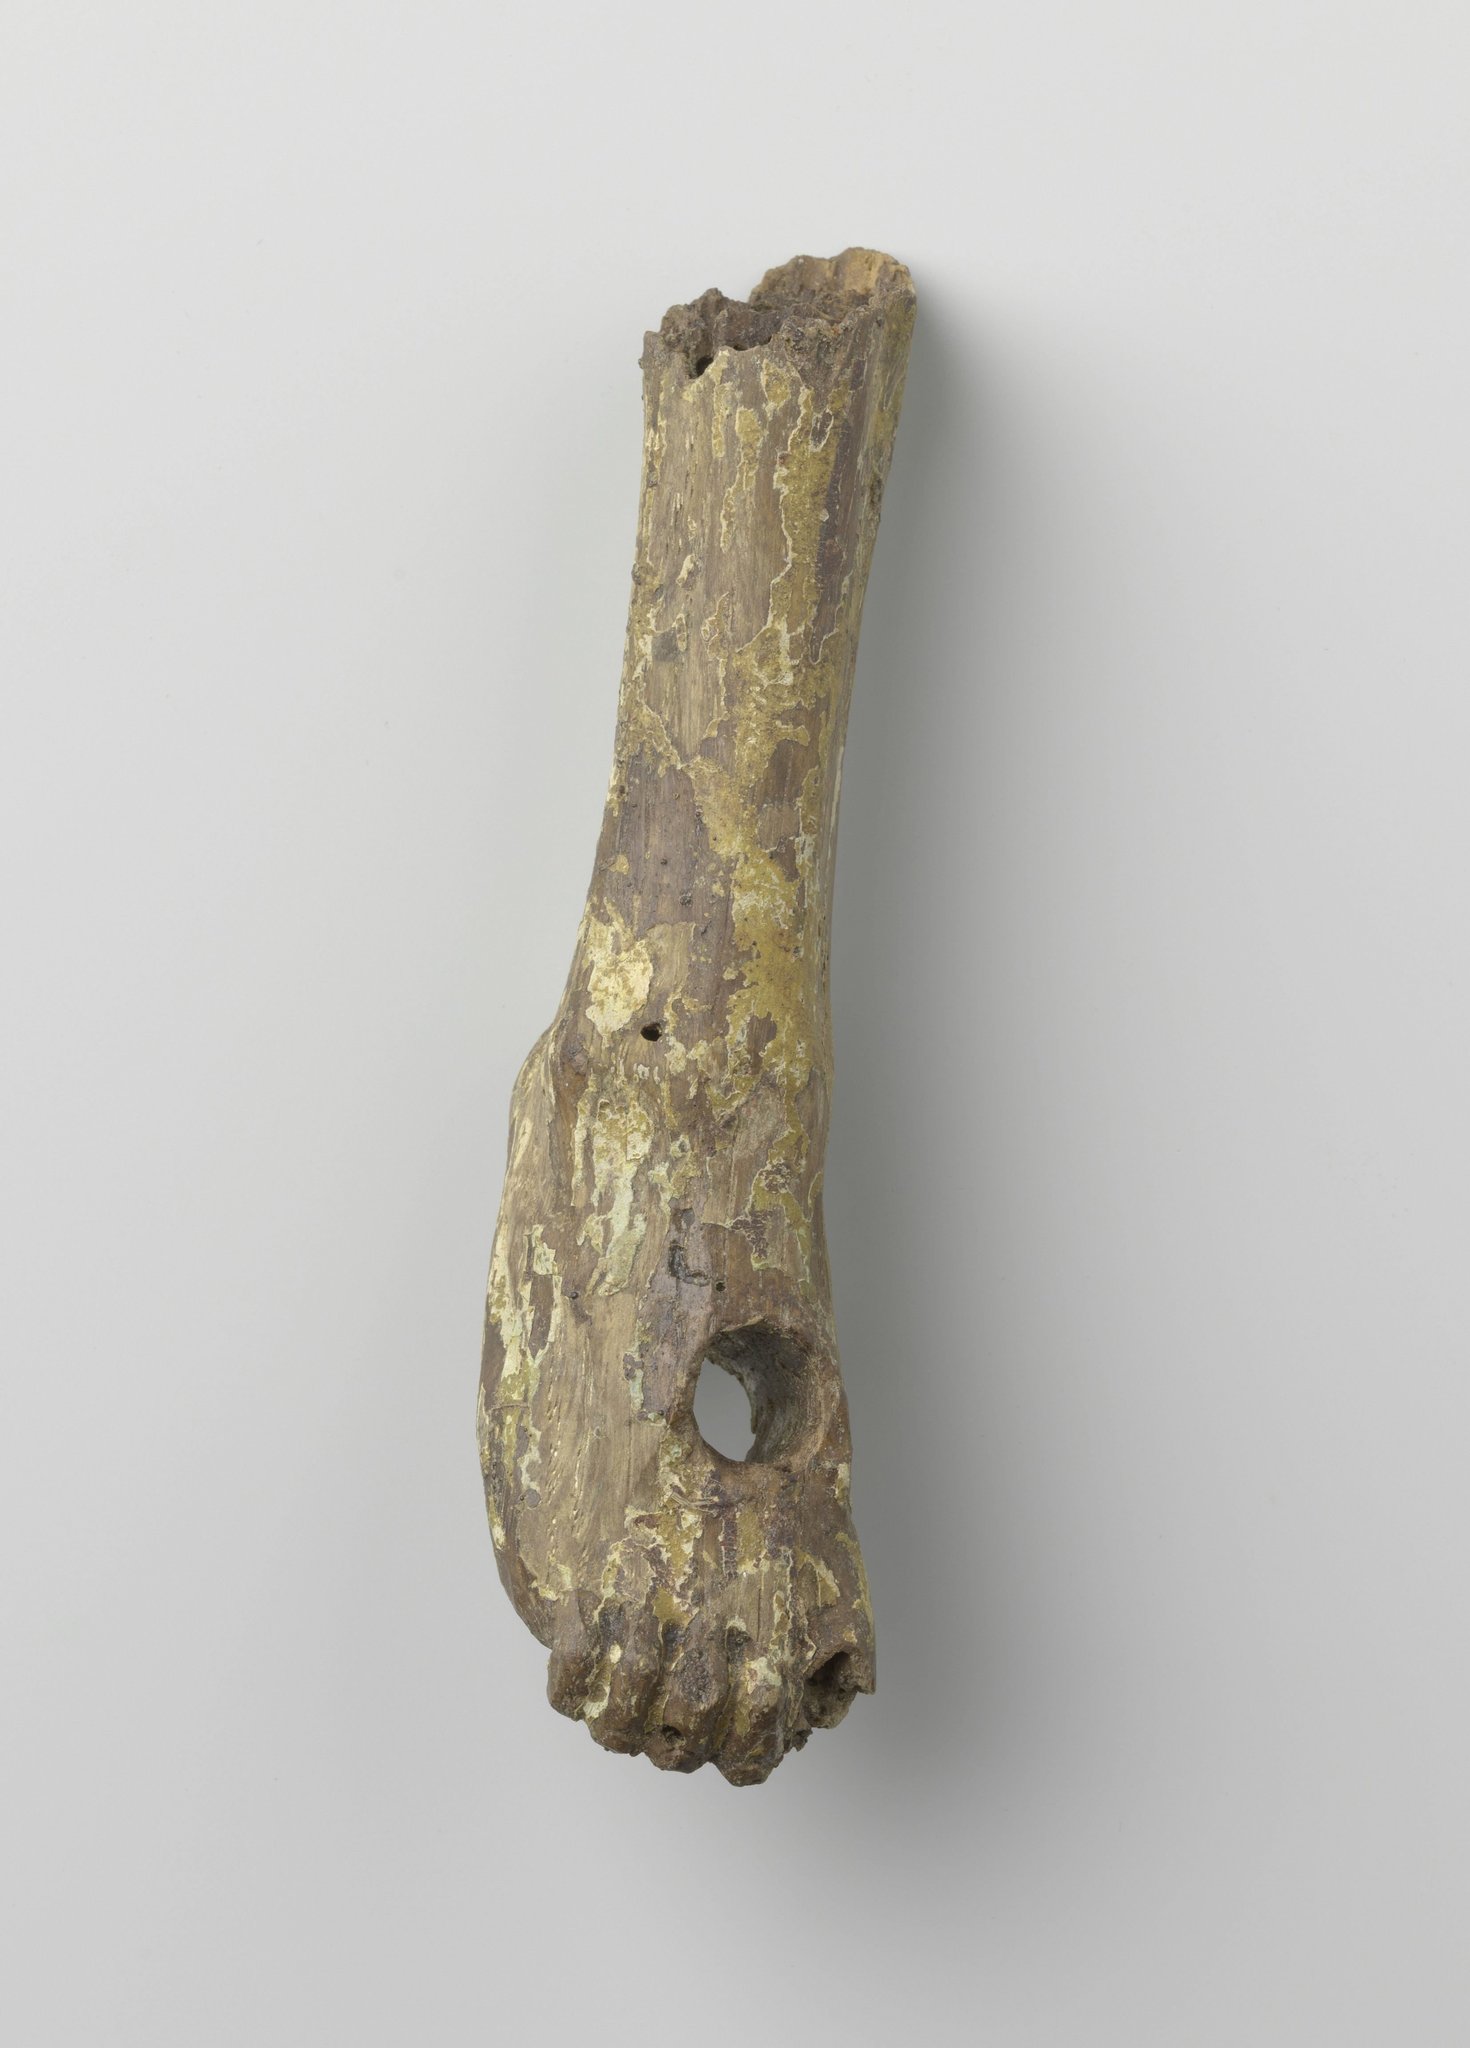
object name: fragment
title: The Pierced Foot of Christ on the Cross, from a Calvary, from the Soest Altarpiece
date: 1475-1499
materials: wood